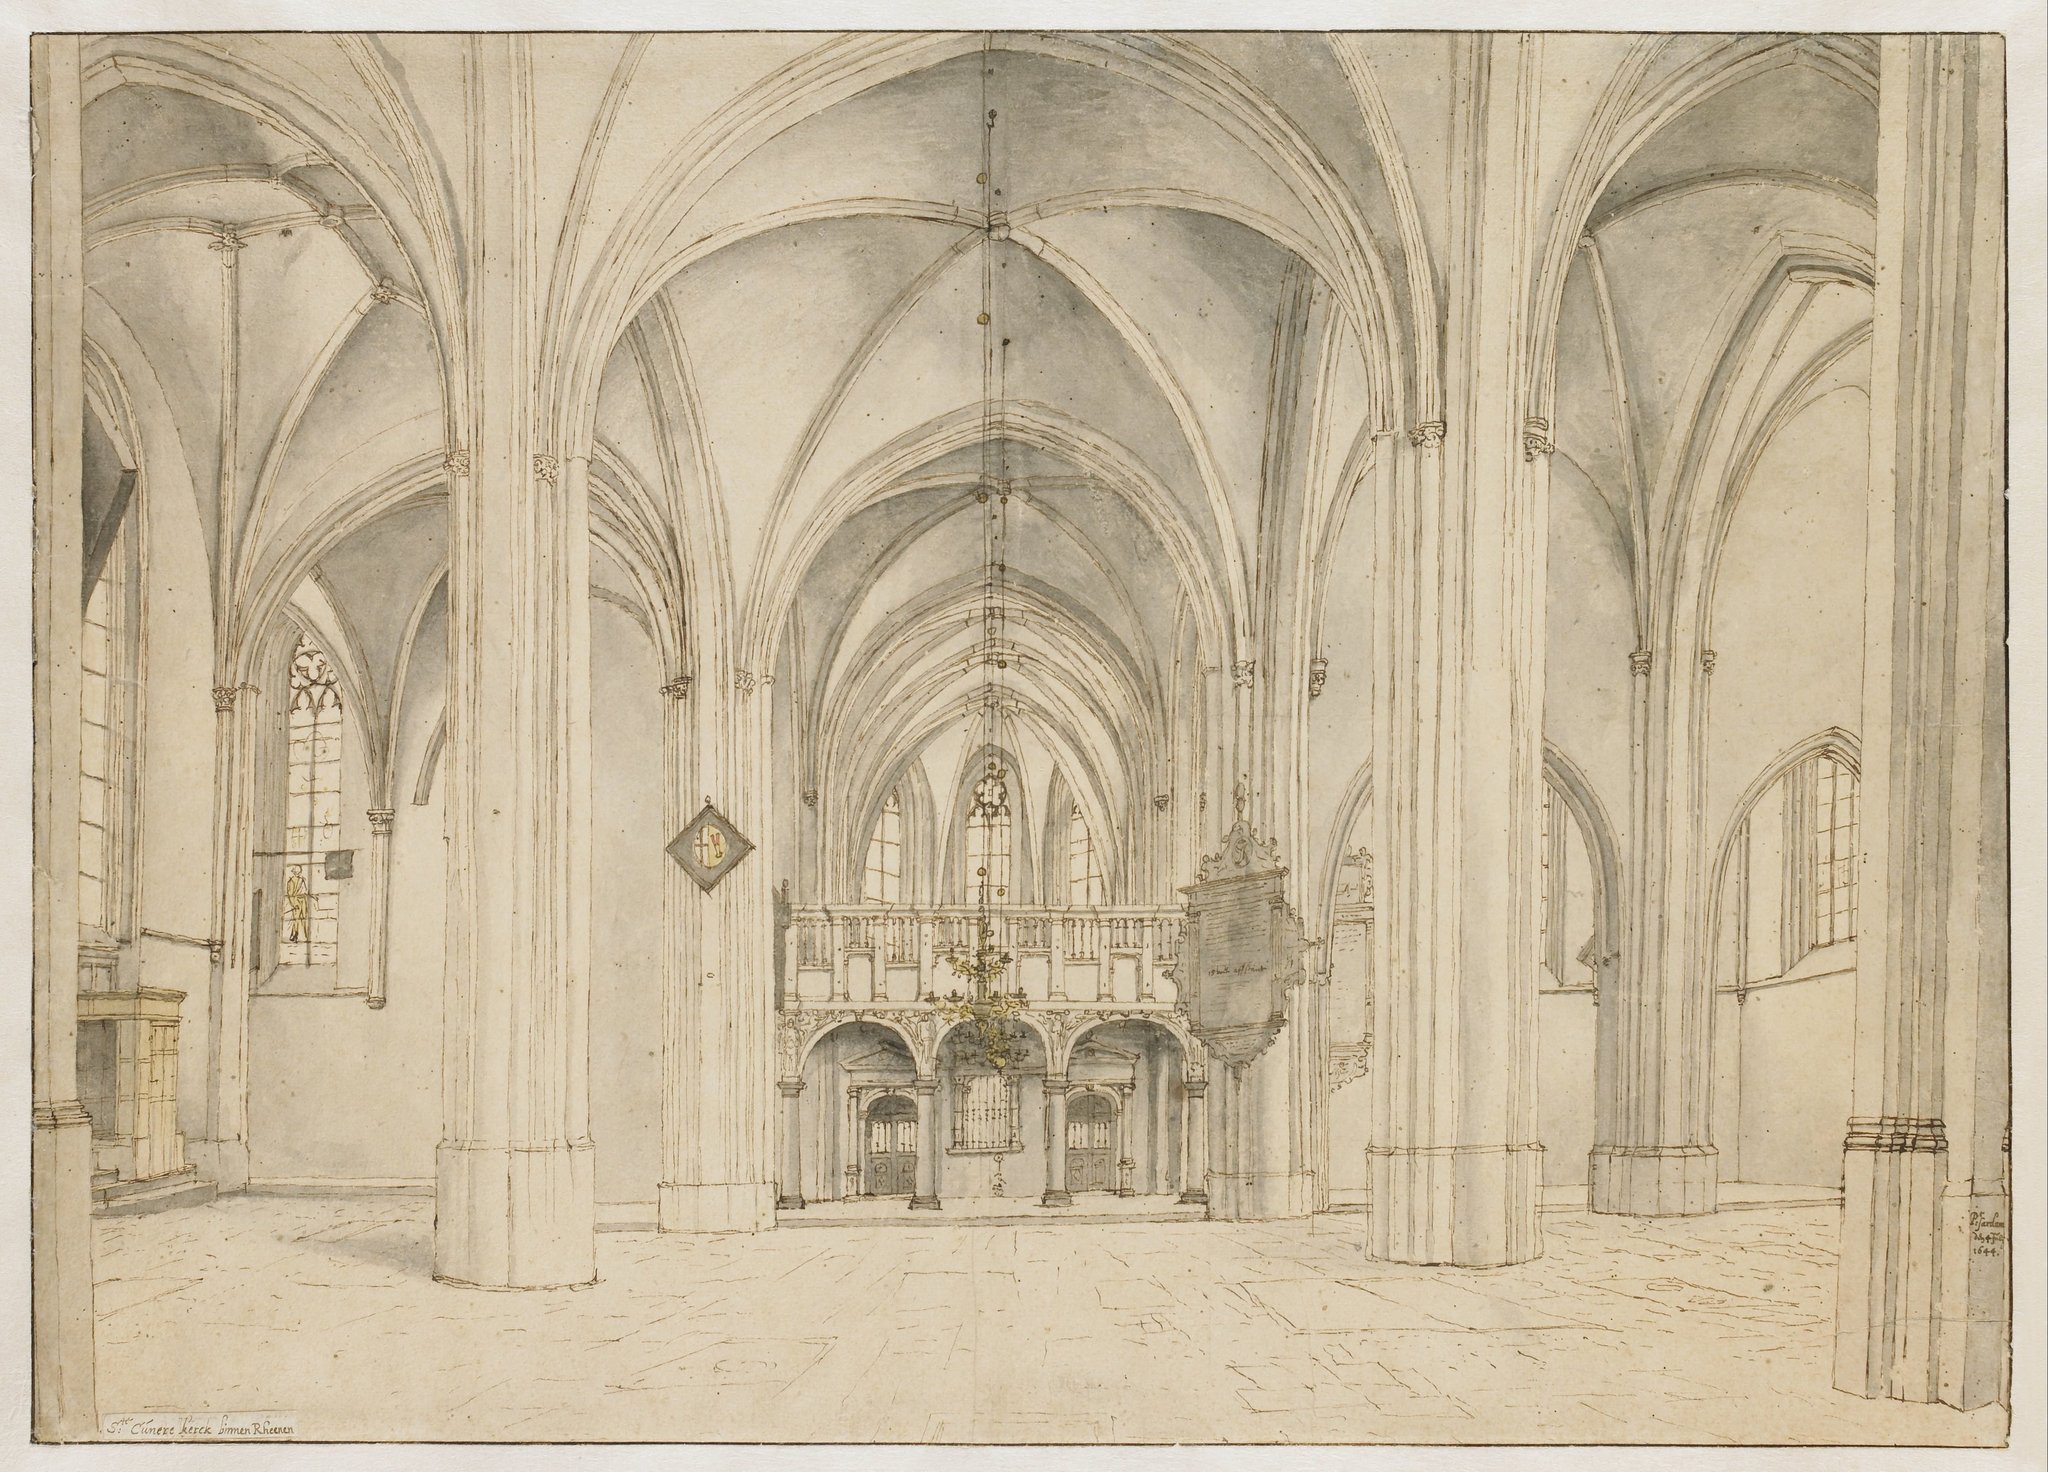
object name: drawing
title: View of the Nave and Choir of the Sint-Cunerakerk, Rhenen, Looking East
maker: pieter jansz saenredam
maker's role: draughtsman, painter, print maker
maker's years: 1597-1665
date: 1644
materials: ink, paper, watercolor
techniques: brush, pen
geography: rhenen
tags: interior of church, rhenen